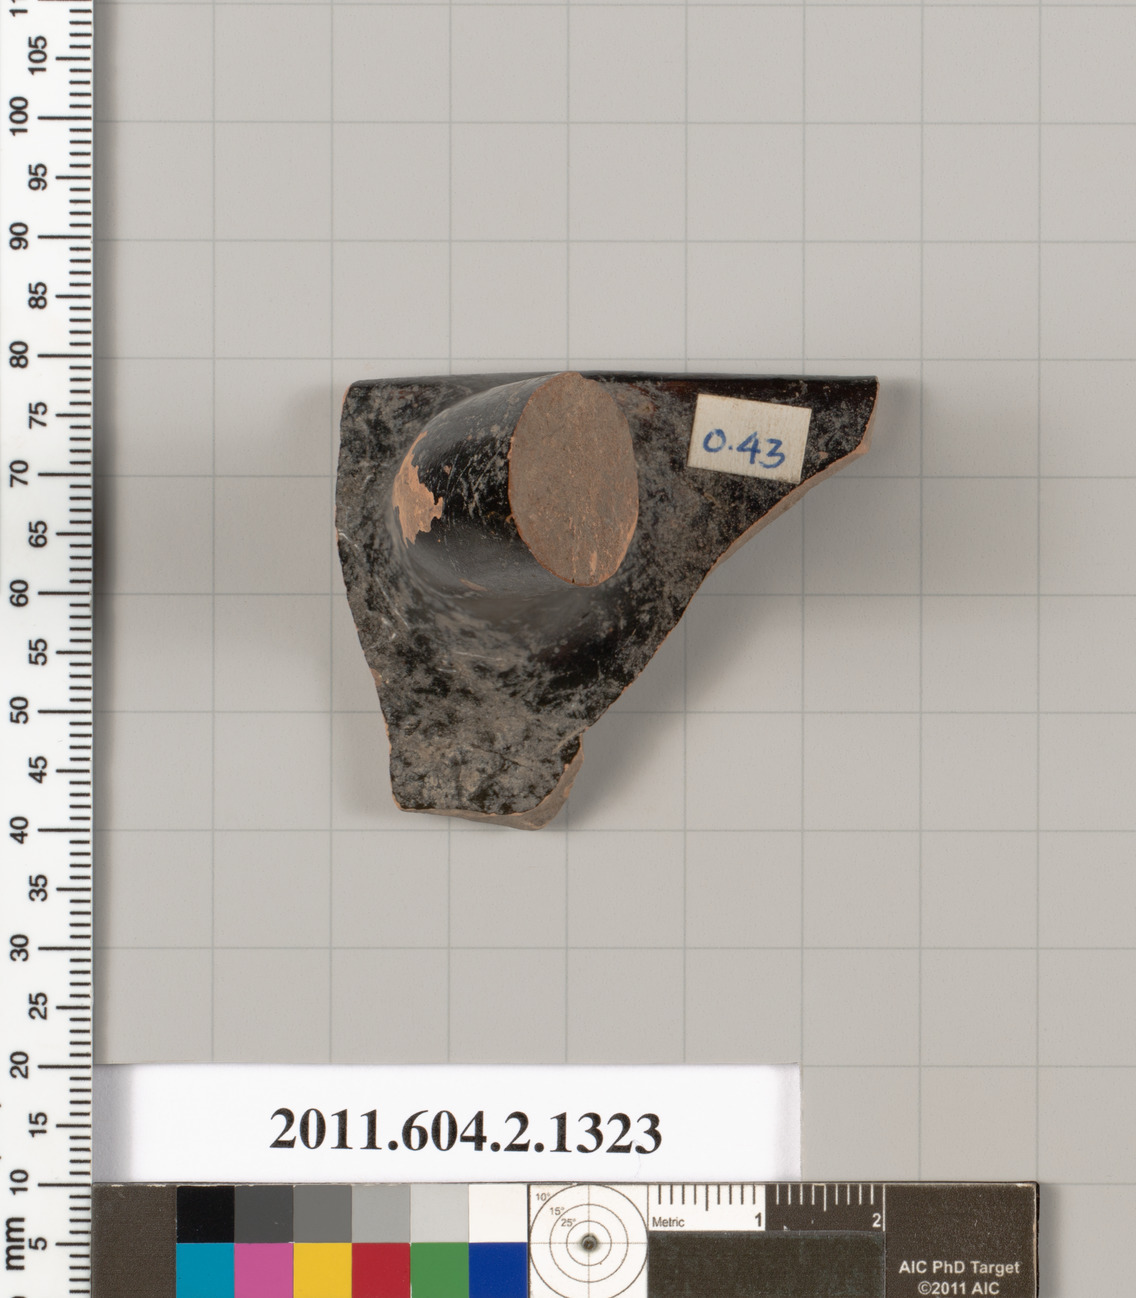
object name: skyphos fragment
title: Terracotta fragment of a skyphos (deep drinking cup)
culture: greek, attic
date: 500-451 BCE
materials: terracotta